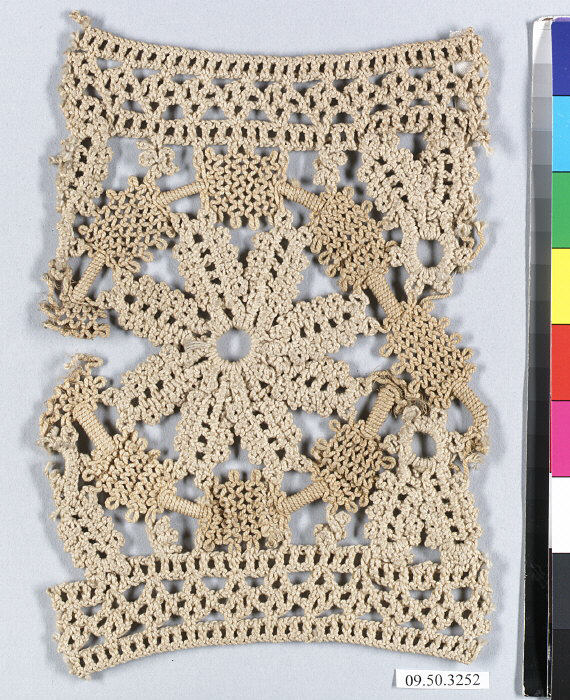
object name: sample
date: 1801-1900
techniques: crochet